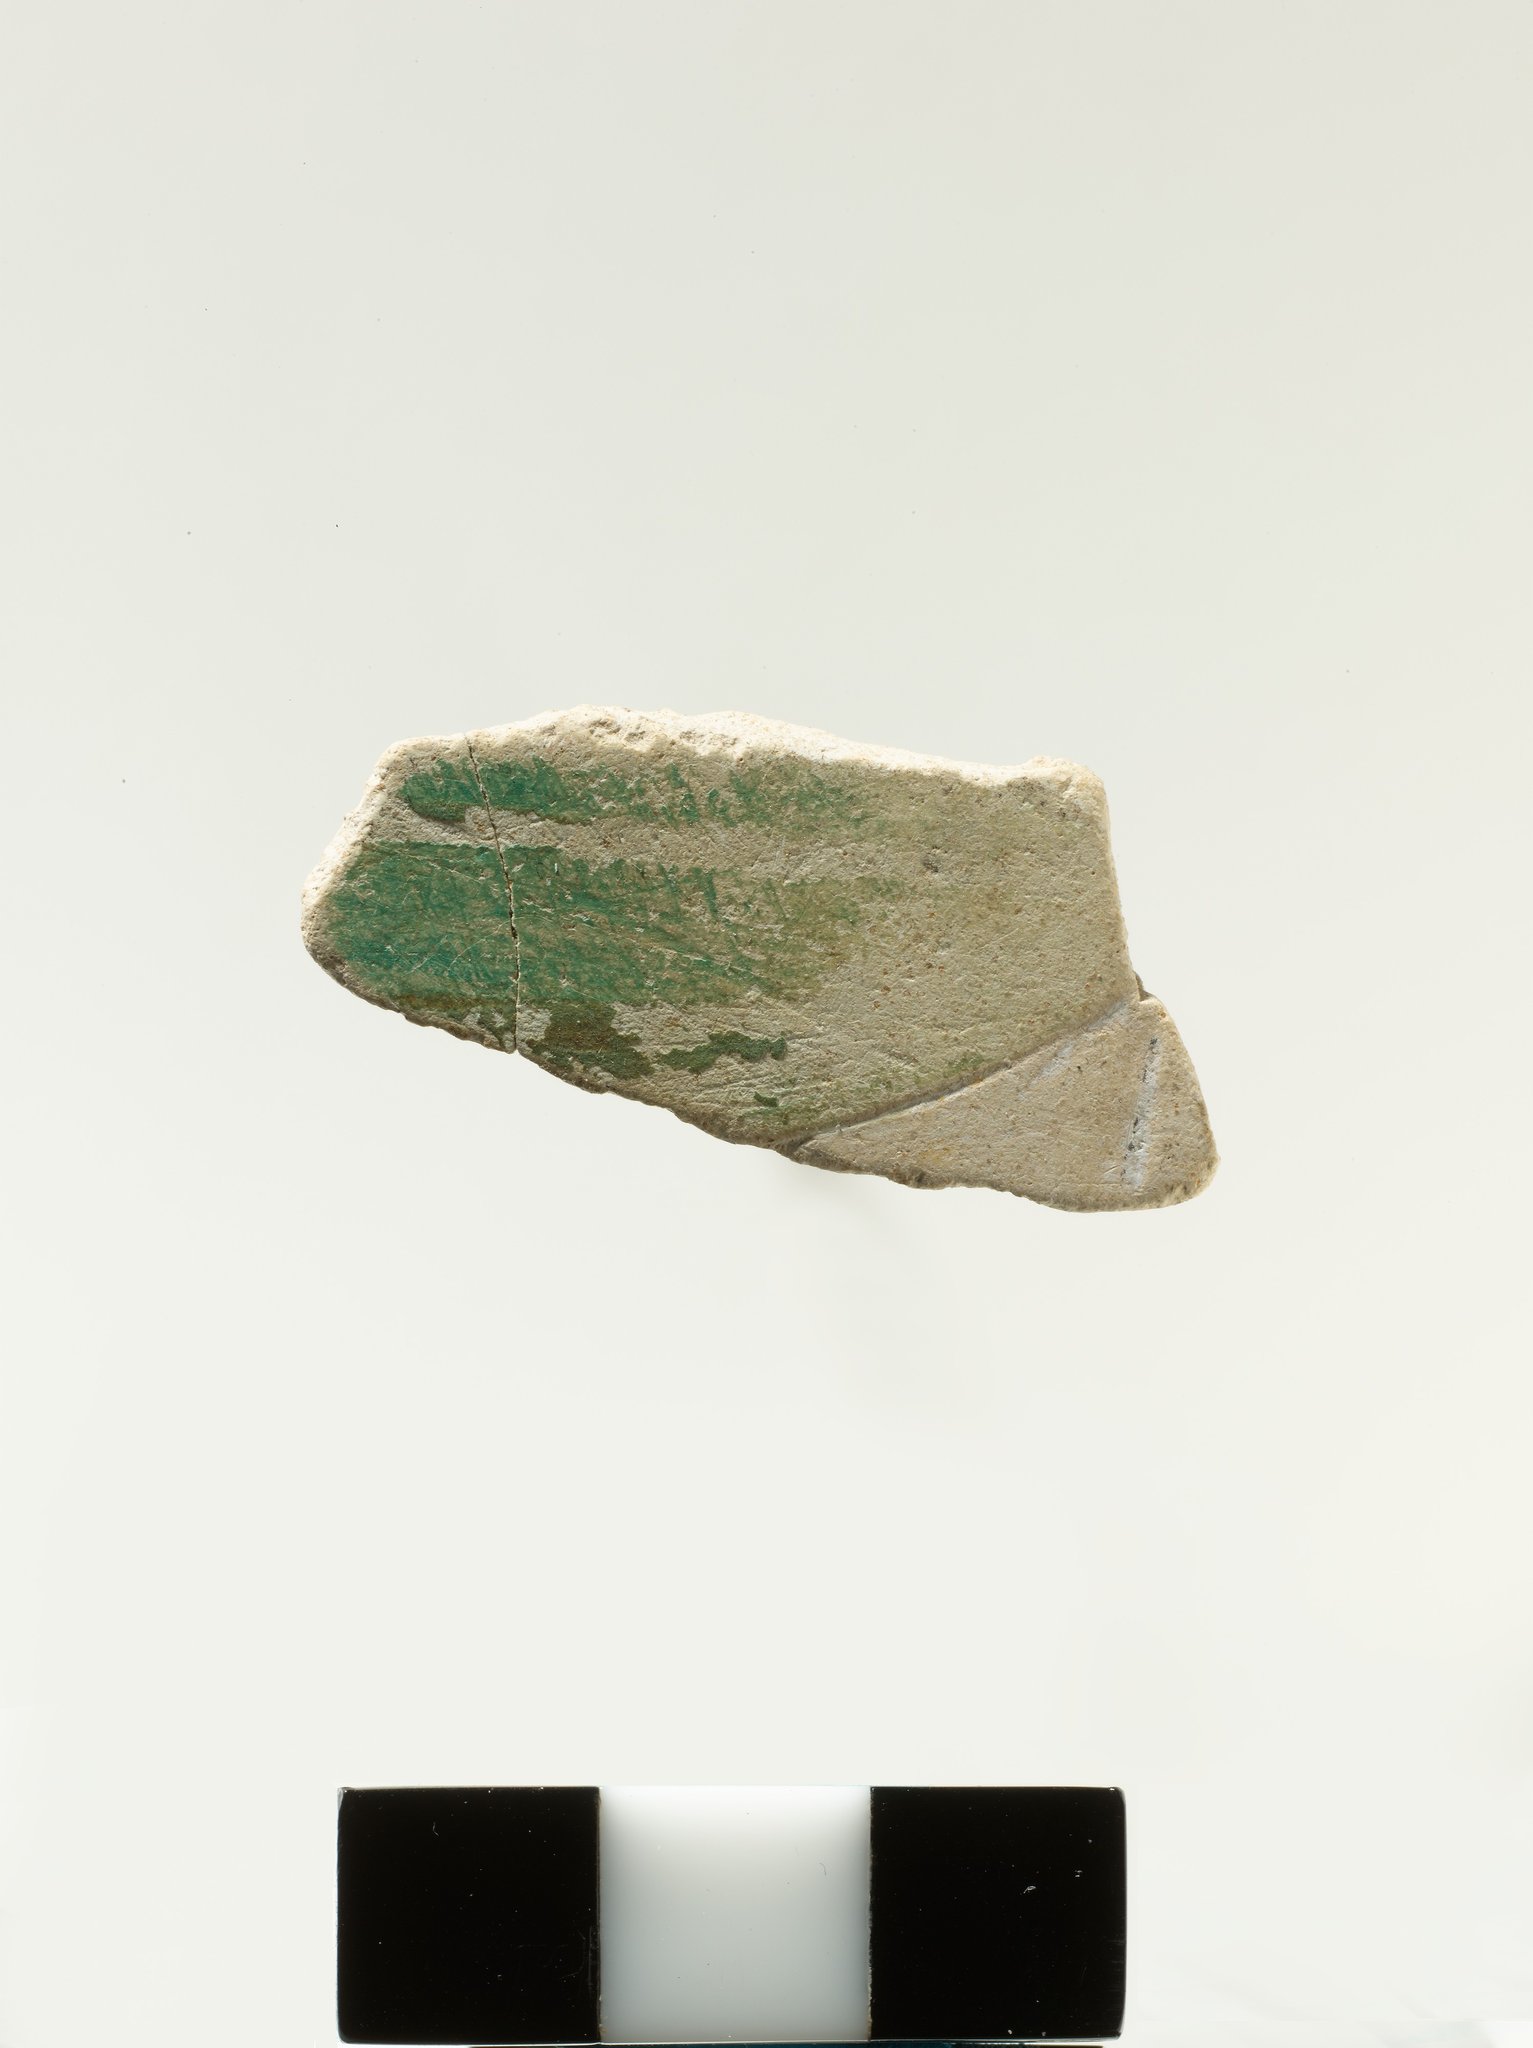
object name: relief fragment, tomb of meketre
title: Relief fragment from the tomb of Meketre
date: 1981-1975 BCE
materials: limestone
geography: egypt